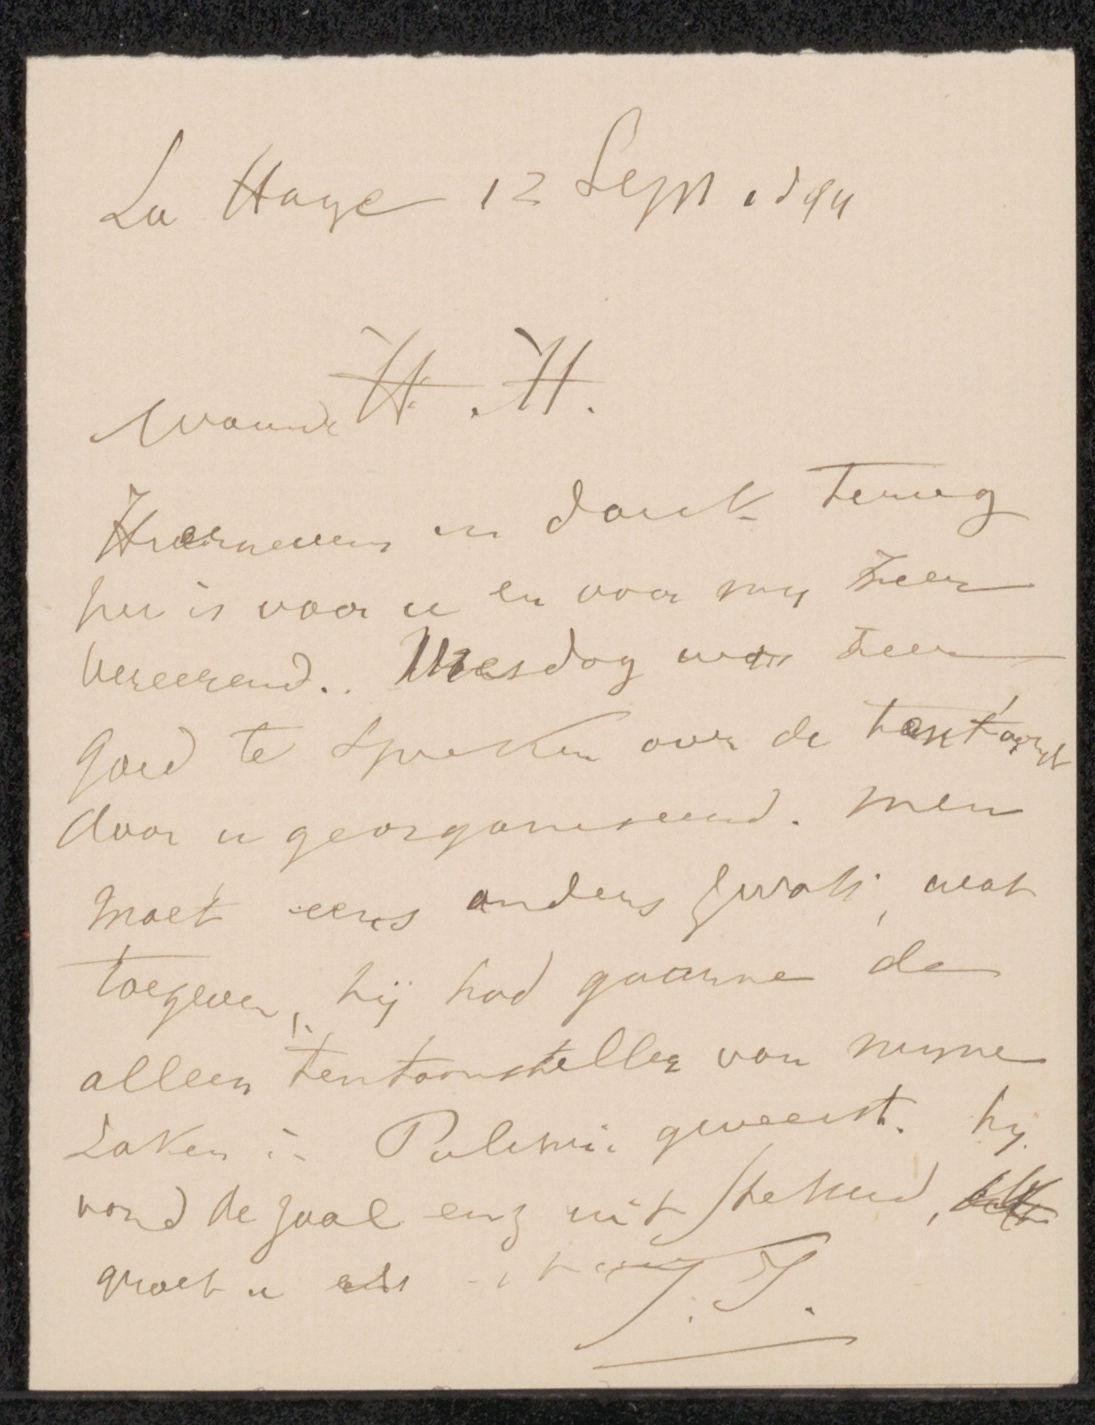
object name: letter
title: Brief aan Pieter Haverkorn van Rijsewijk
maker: jozef israëls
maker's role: draughtsman, painter, print maker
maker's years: 1824-1911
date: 1894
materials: ink, paper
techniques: pen, writing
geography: the hague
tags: hendrik willem mesdag, pieter haverkorn van rijsewijk, exhibition ~ art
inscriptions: collector's mark: ‘RPK’